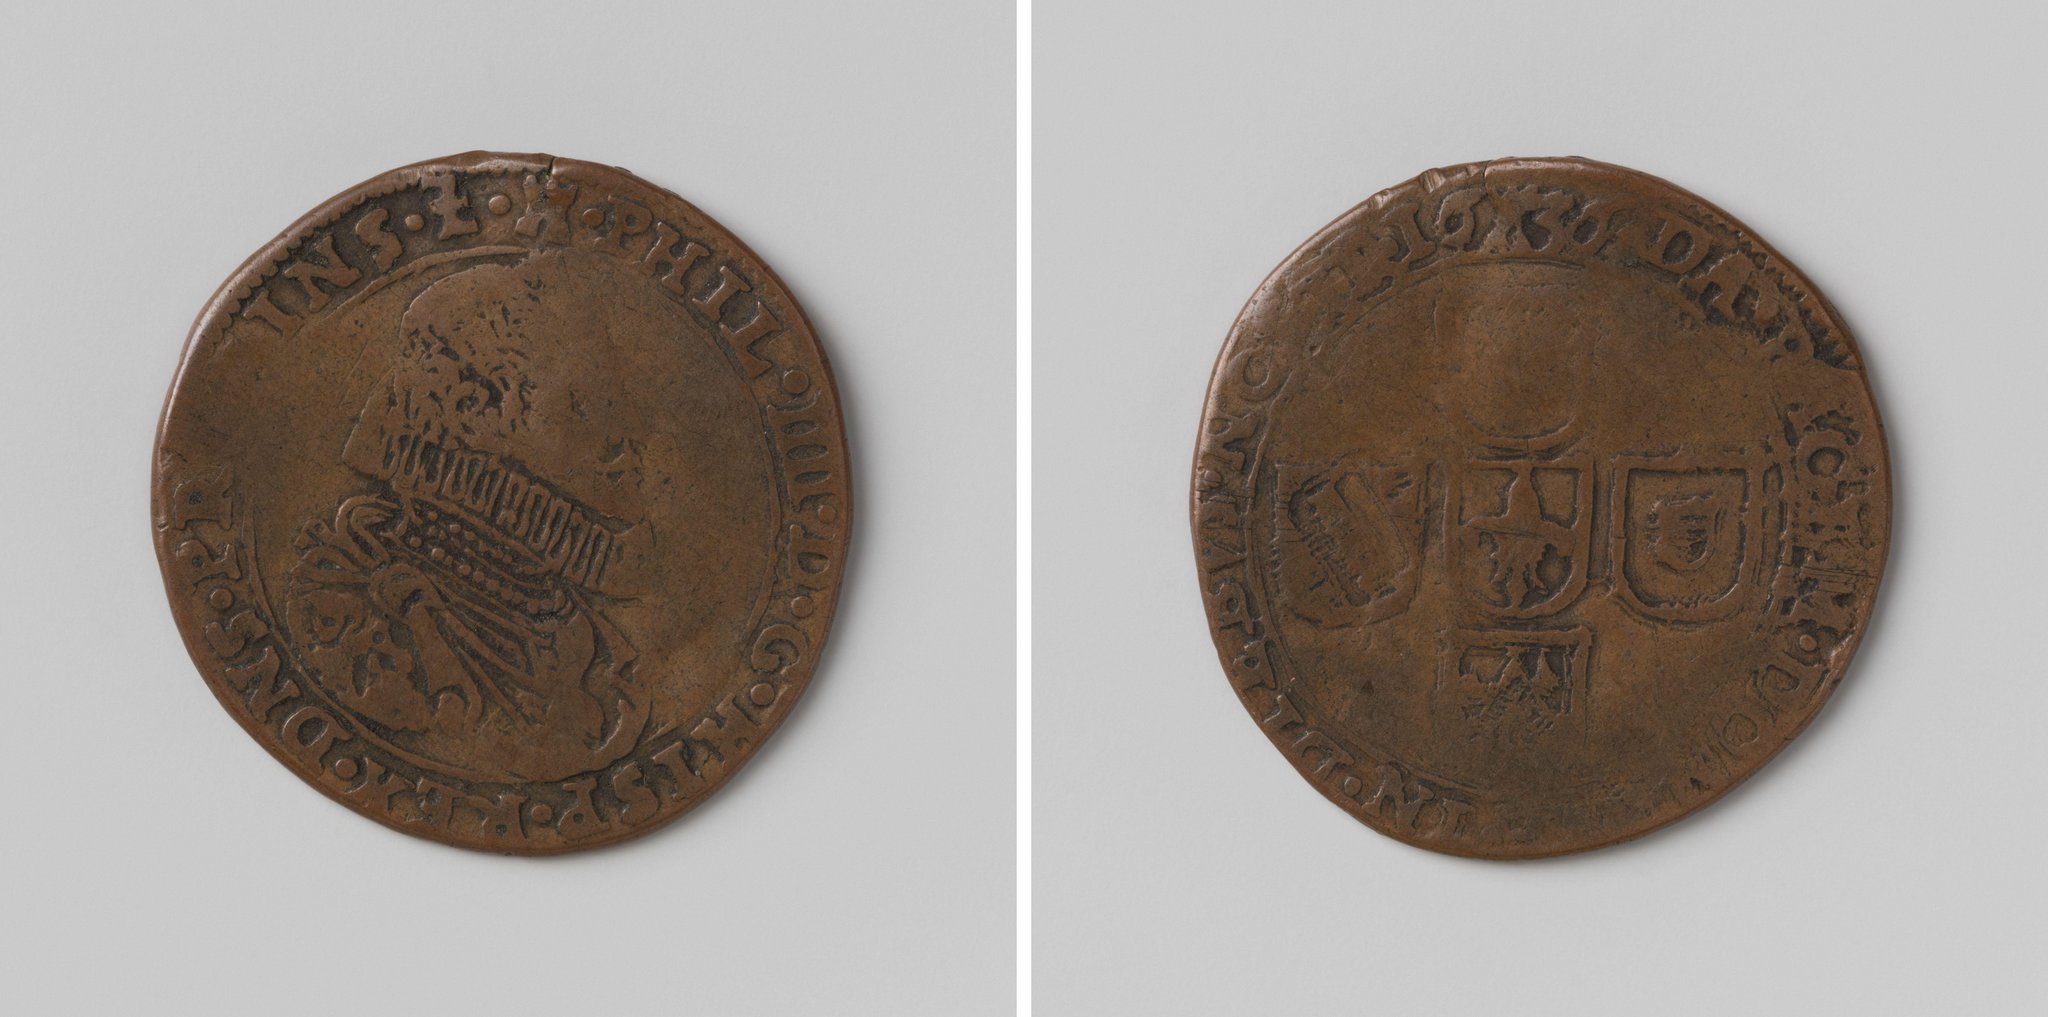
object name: jeton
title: Hoop op vrede, rekenpenning geslagen ter ere van Filips IV, koning van Spanje, op last van de Staten van Rijssel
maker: Anonymous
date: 1636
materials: copper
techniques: striking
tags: filips iv (koning van spanje), lille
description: Koperen penning. Voorzijde: borststuk man binnen omschrift. Keerzijde: wapenschild, omgeven door vier wapenschilden binnen omschrift